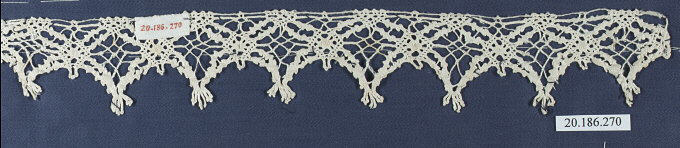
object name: edging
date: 1501-1600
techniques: lace